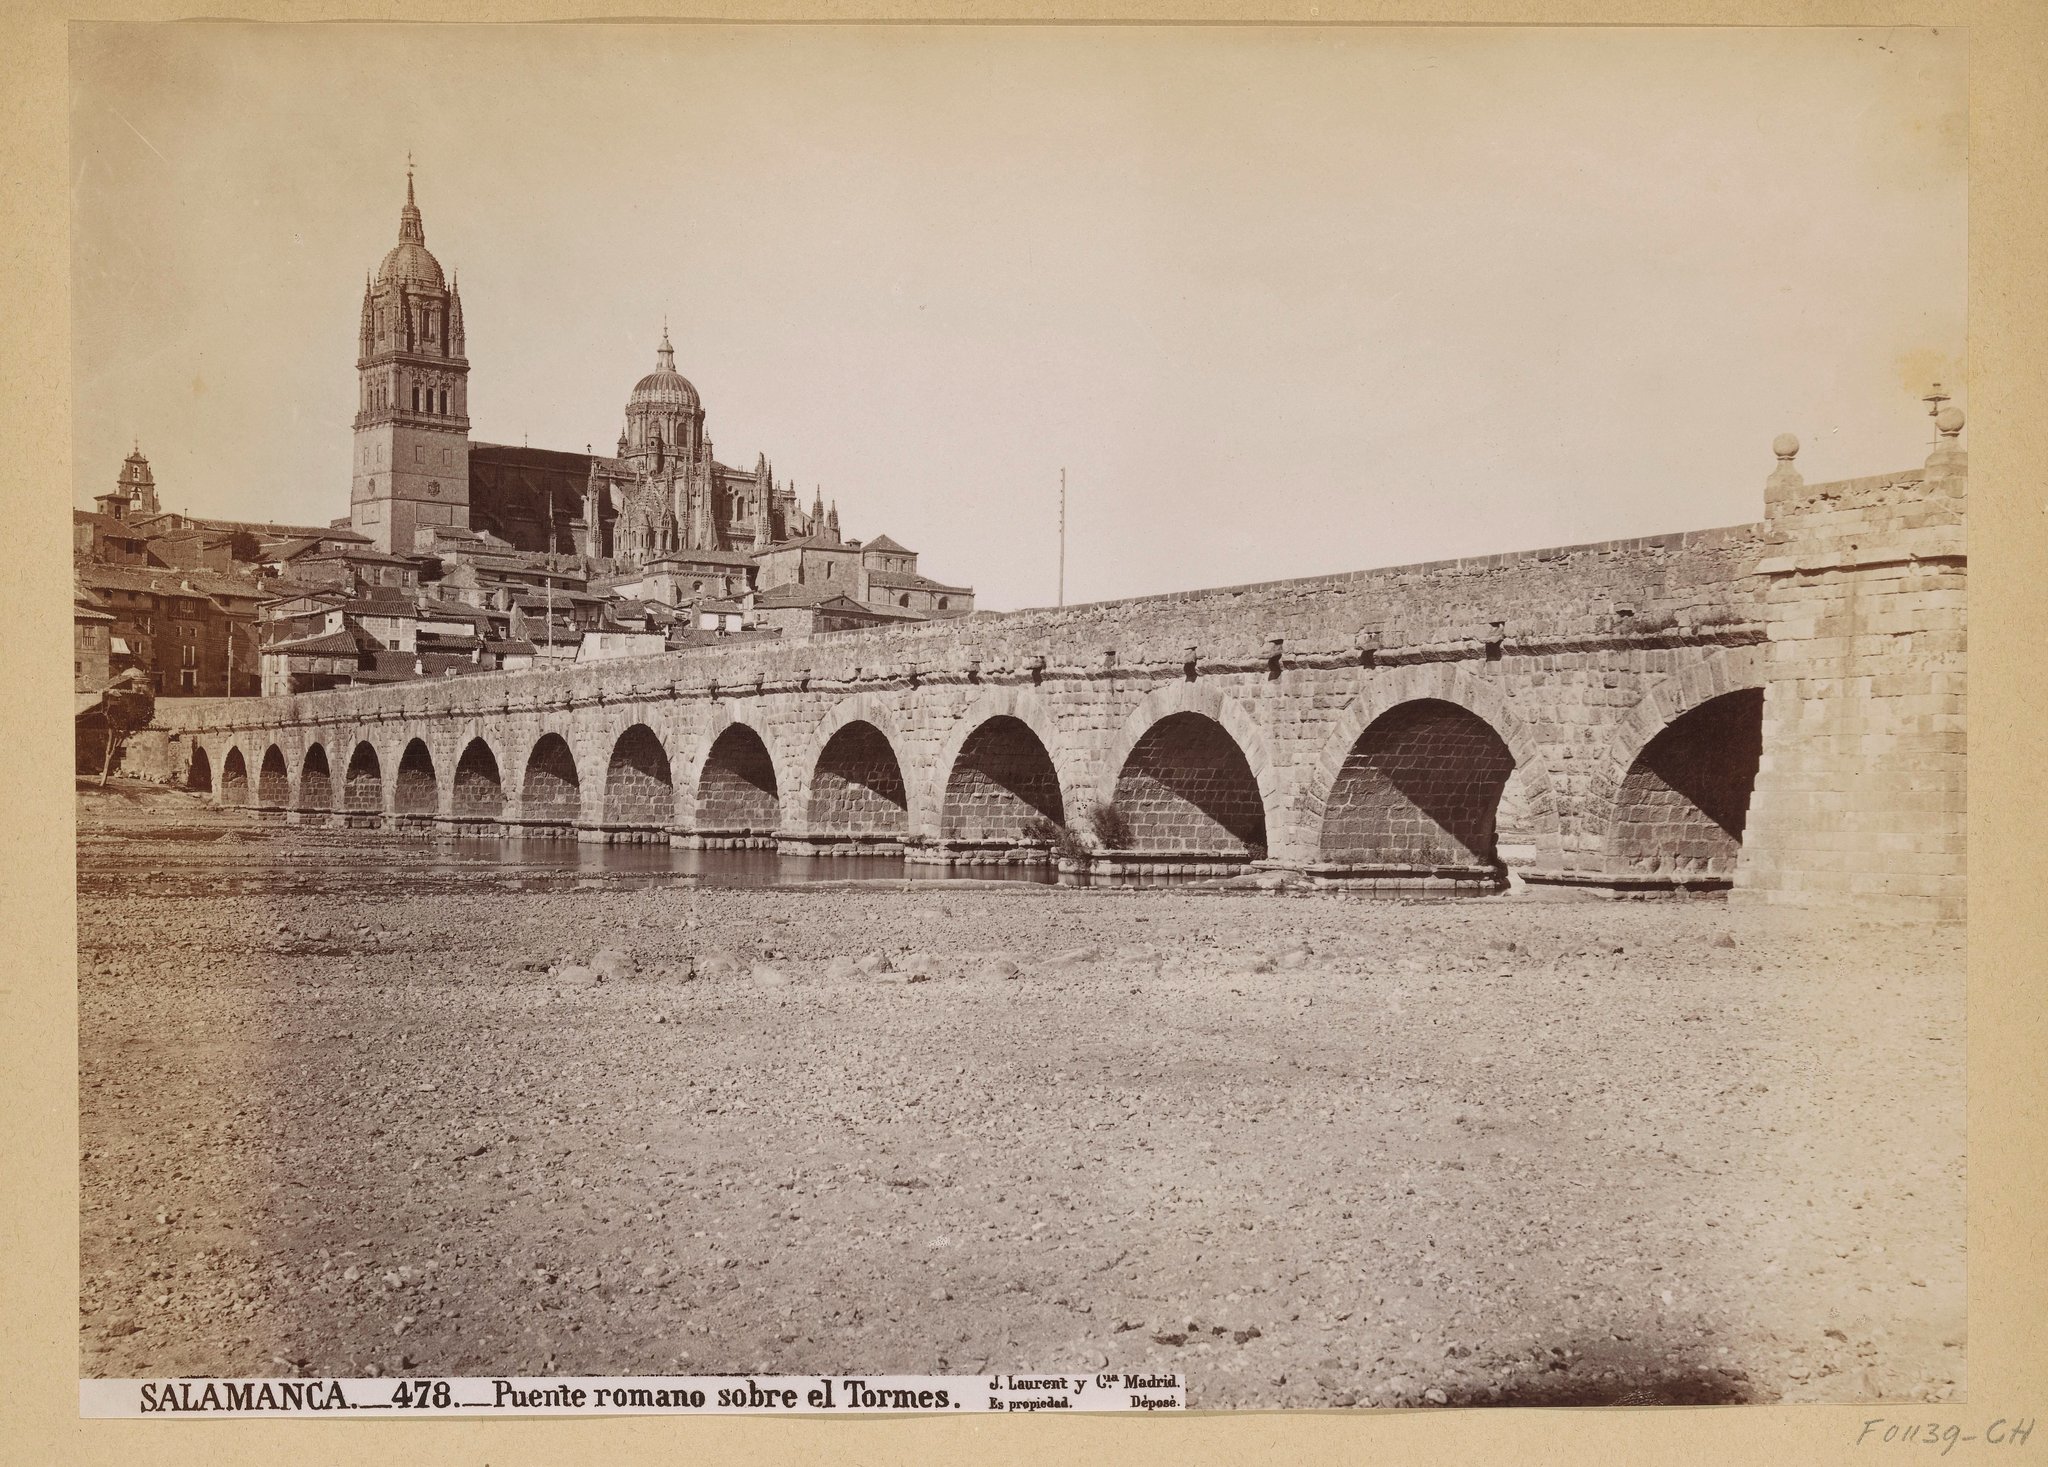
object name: album leaf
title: Gezicht op de Puente Mayor del Tormes in Salamanca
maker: juan laurent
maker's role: publisher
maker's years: 1816-1896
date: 1863-1883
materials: paper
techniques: albumen print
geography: salamanca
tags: bridge in city across river, canal, etc.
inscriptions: inscription: ‘Es propiedad./ Déposé.’, number: ‘478’